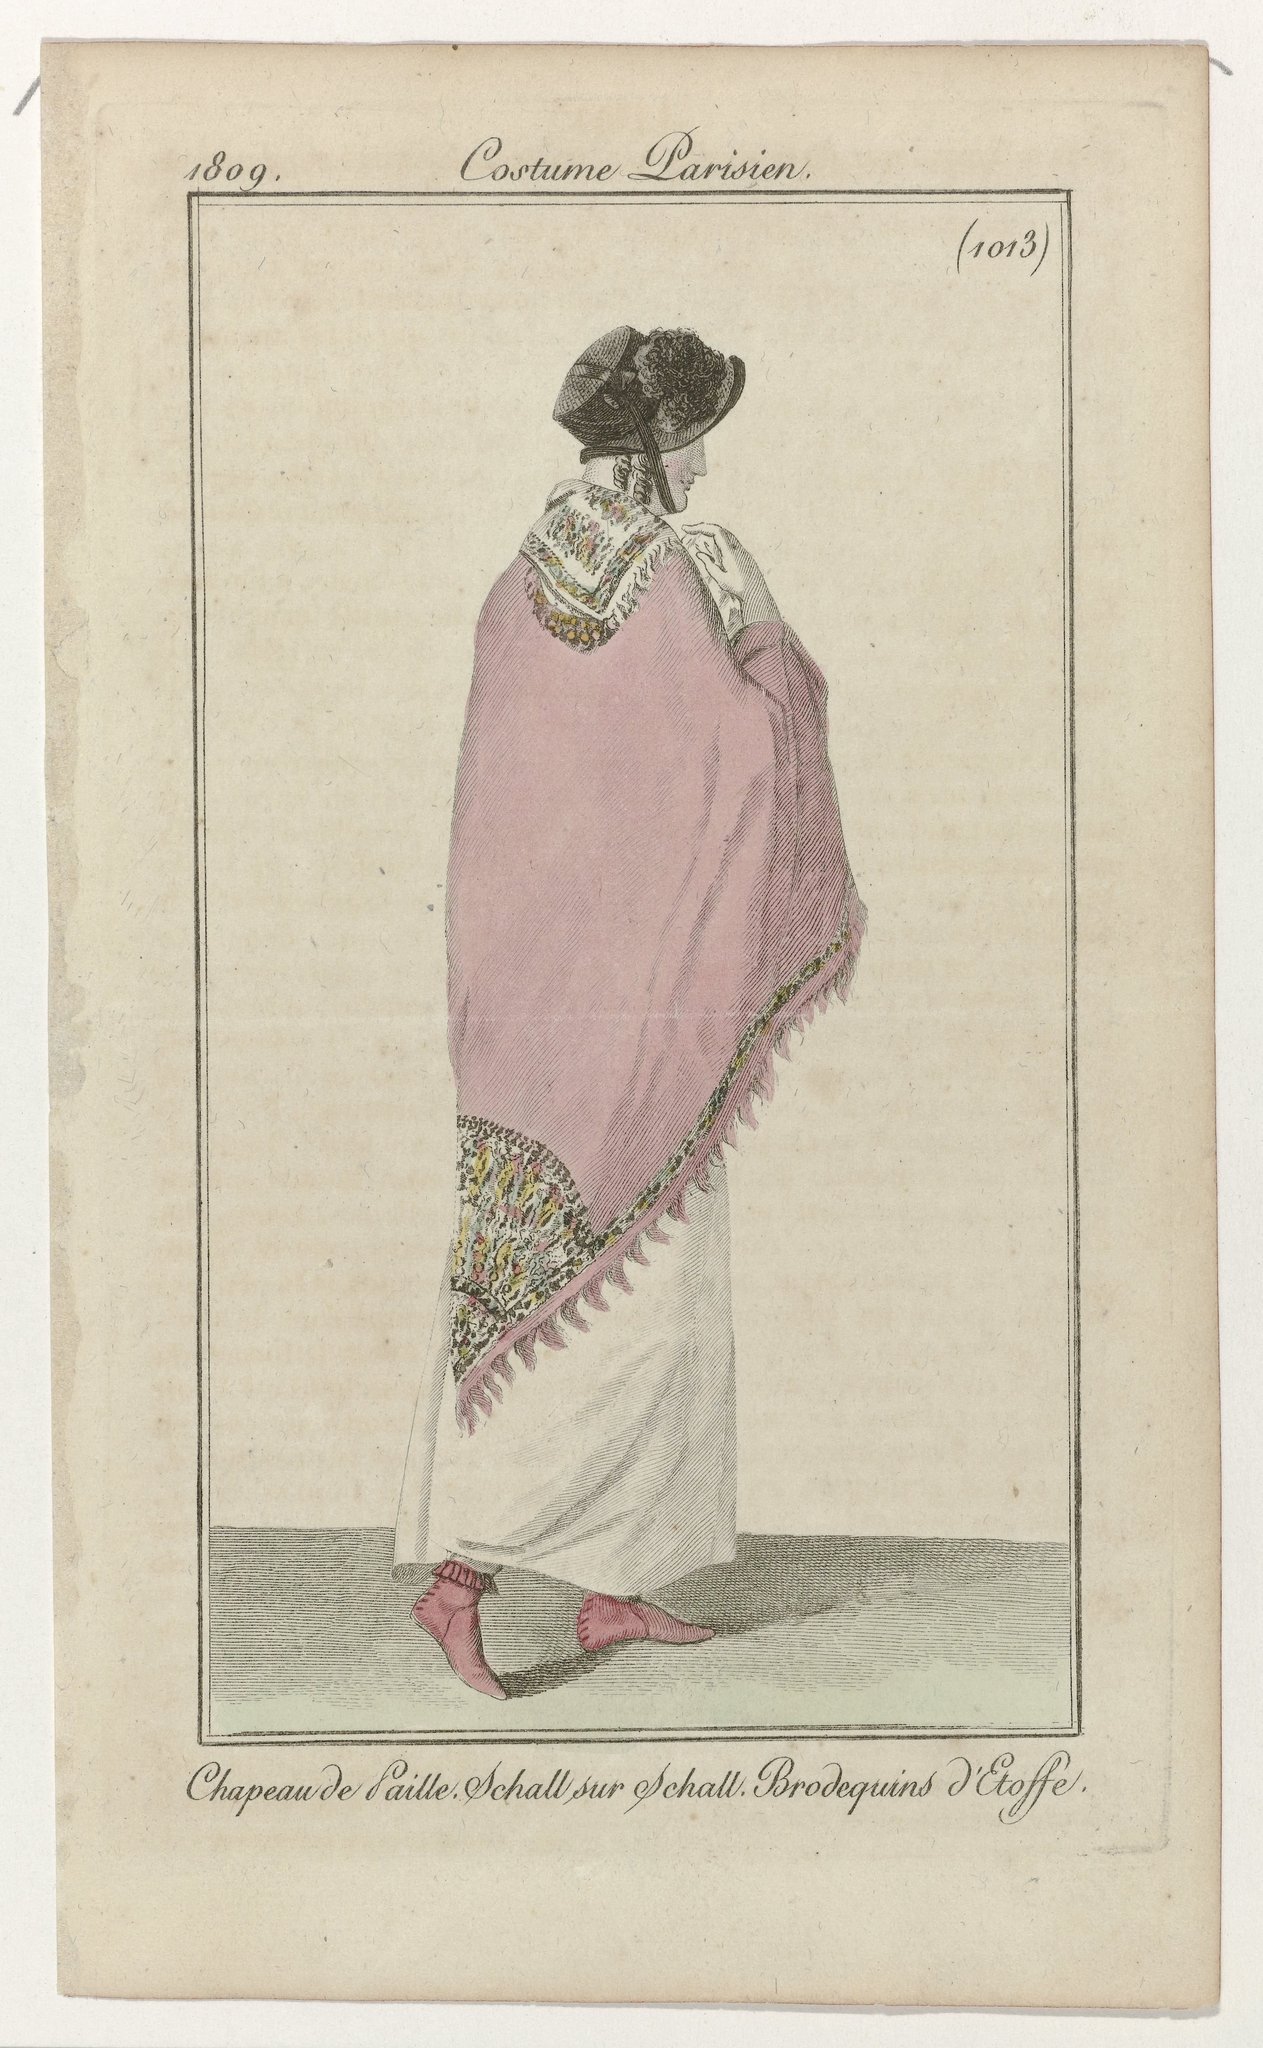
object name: fashion print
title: Journal des Dames et des Modes, Costume Parisien, 25 octobre 1809, (1013): Chapeau de paill (...)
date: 1809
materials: paper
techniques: engraving, hand coloring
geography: paris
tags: clothing for the upper part of the body (shawl) (+ women's clothes), head-gear (straw hat) (+ women's clothes), fashion plates, skirt (+ women's clothes)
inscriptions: caption: ‘Chapeau de Paille. Schall sur schall. Brodequins d'Etoffe.’, title: ‘Costume Parisien.’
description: Vrouw, op de rug gezien, lopend naar rechts, met op het hoofd een strohoed. Om de schouders een sjaal over een andere sjaal, beiden afgezet met franjes. Witte rok. Laarzen van stof. De prent maakt deel uit van het modetijdschrift Journal des Dames et des Modes, uitgegeven door Pierre de la Mésangère, Parijs, 1797-1839.